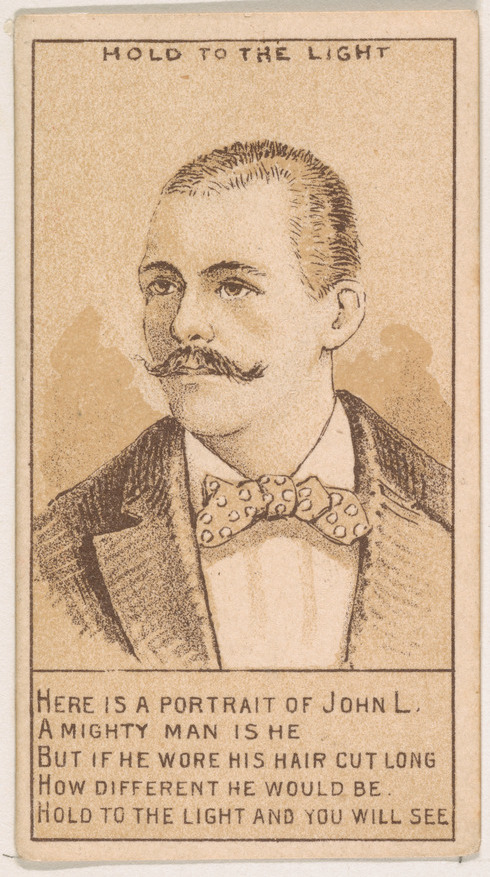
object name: print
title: Here is a Portrait of John L..., from the Magic Changing Cards series (N223) issued by Kinney Tobacco Company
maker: kinney brothers tobacco company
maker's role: publisher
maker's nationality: american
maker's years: 1869-2011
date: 1889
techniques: color lithograph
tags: men